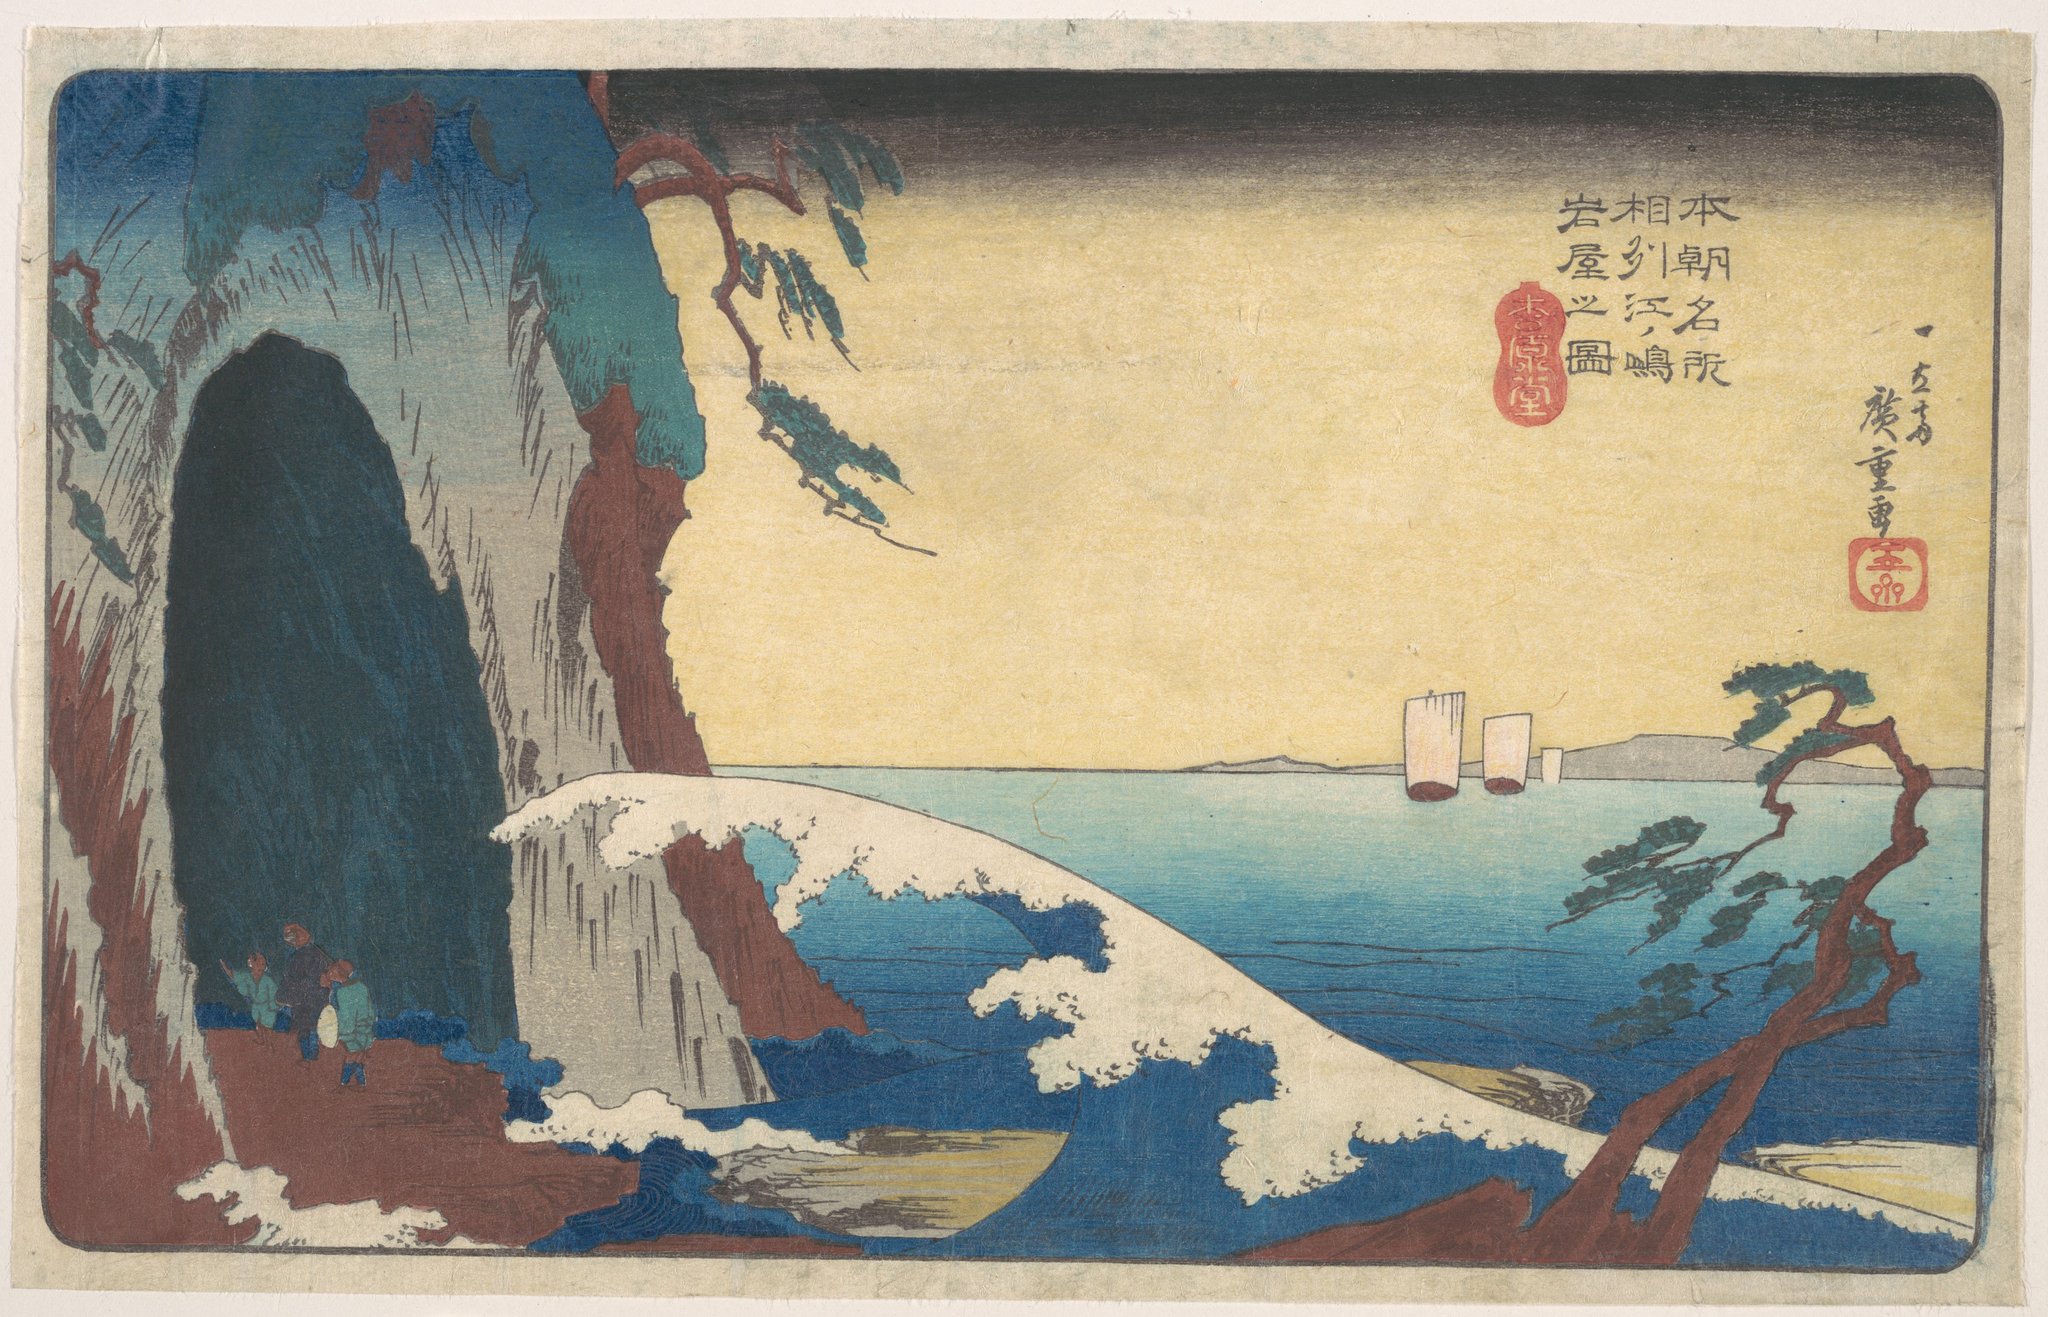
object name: print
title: Sōshū, Enoshima Iwaya no Zu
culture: japanese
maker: utagawa hiroshige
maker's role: artist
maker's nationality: japanese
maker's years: 1797-1858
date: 1797-1858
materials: ink, paper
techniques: woodblock print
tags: caves,landscapes,trees,boats